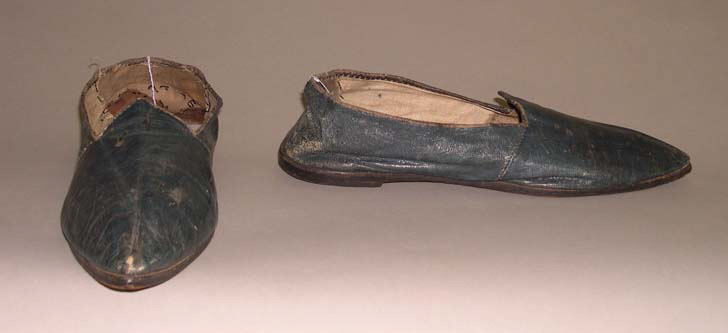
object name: shoe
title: Shoes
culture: british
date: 1780-1799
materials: leather